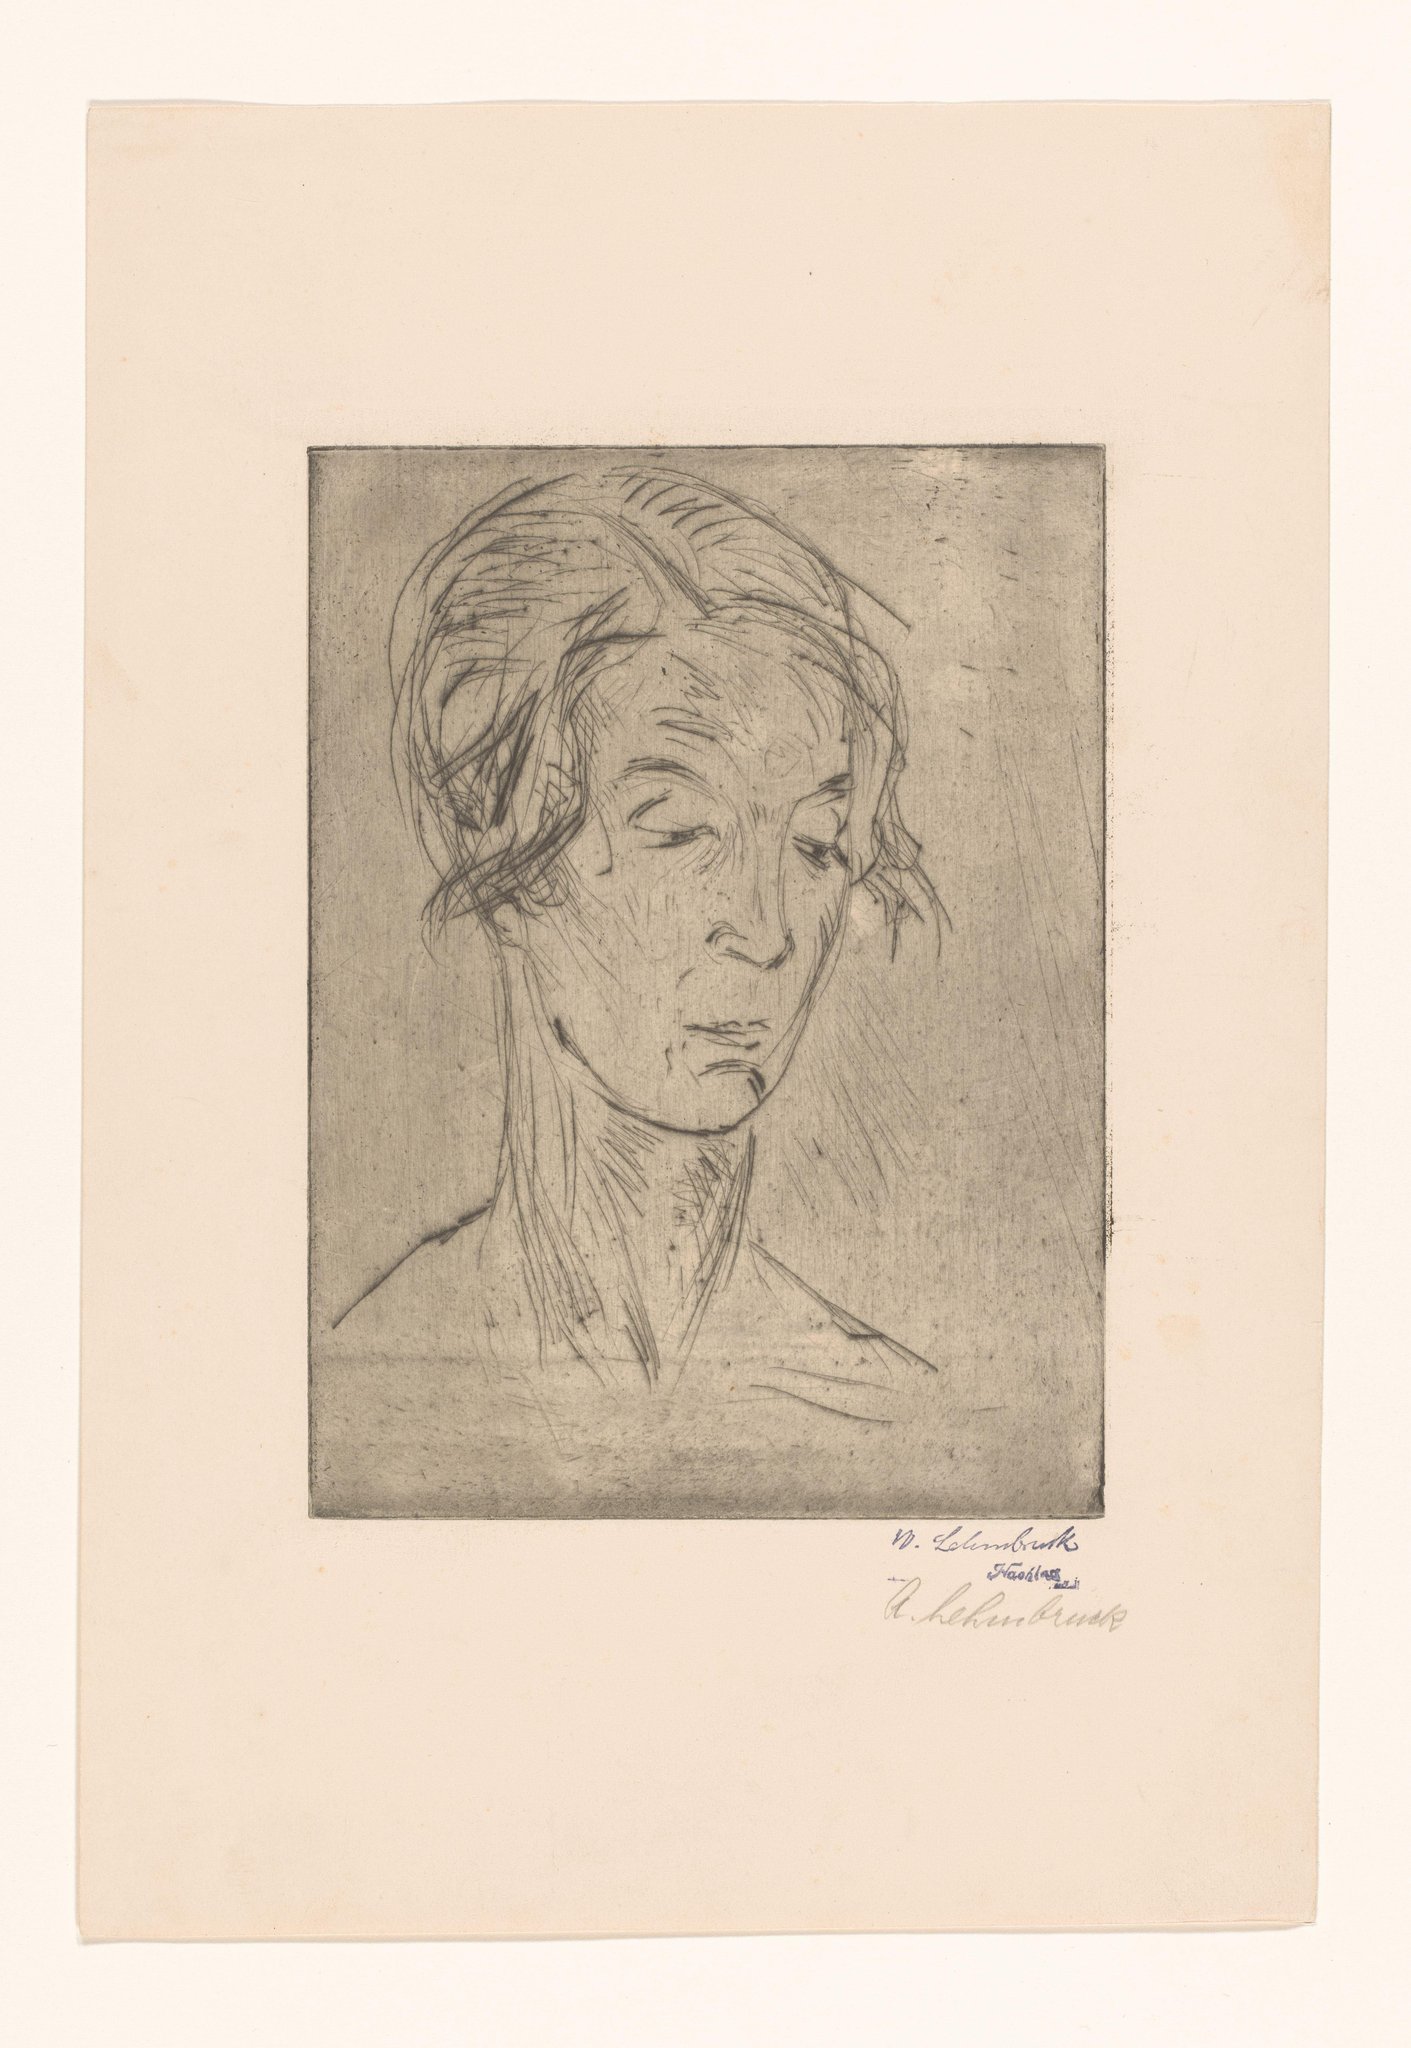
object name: print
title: Hoofd van een vrouw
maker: wilhelm lehmbruck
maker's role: print maker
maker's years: 1881-1919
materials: paper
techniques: drypoint, intaglio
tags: adult woman, anonymous historical person portrayed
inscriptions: collector's mark: Lugt 2228, collector's mark: Lugt 2760